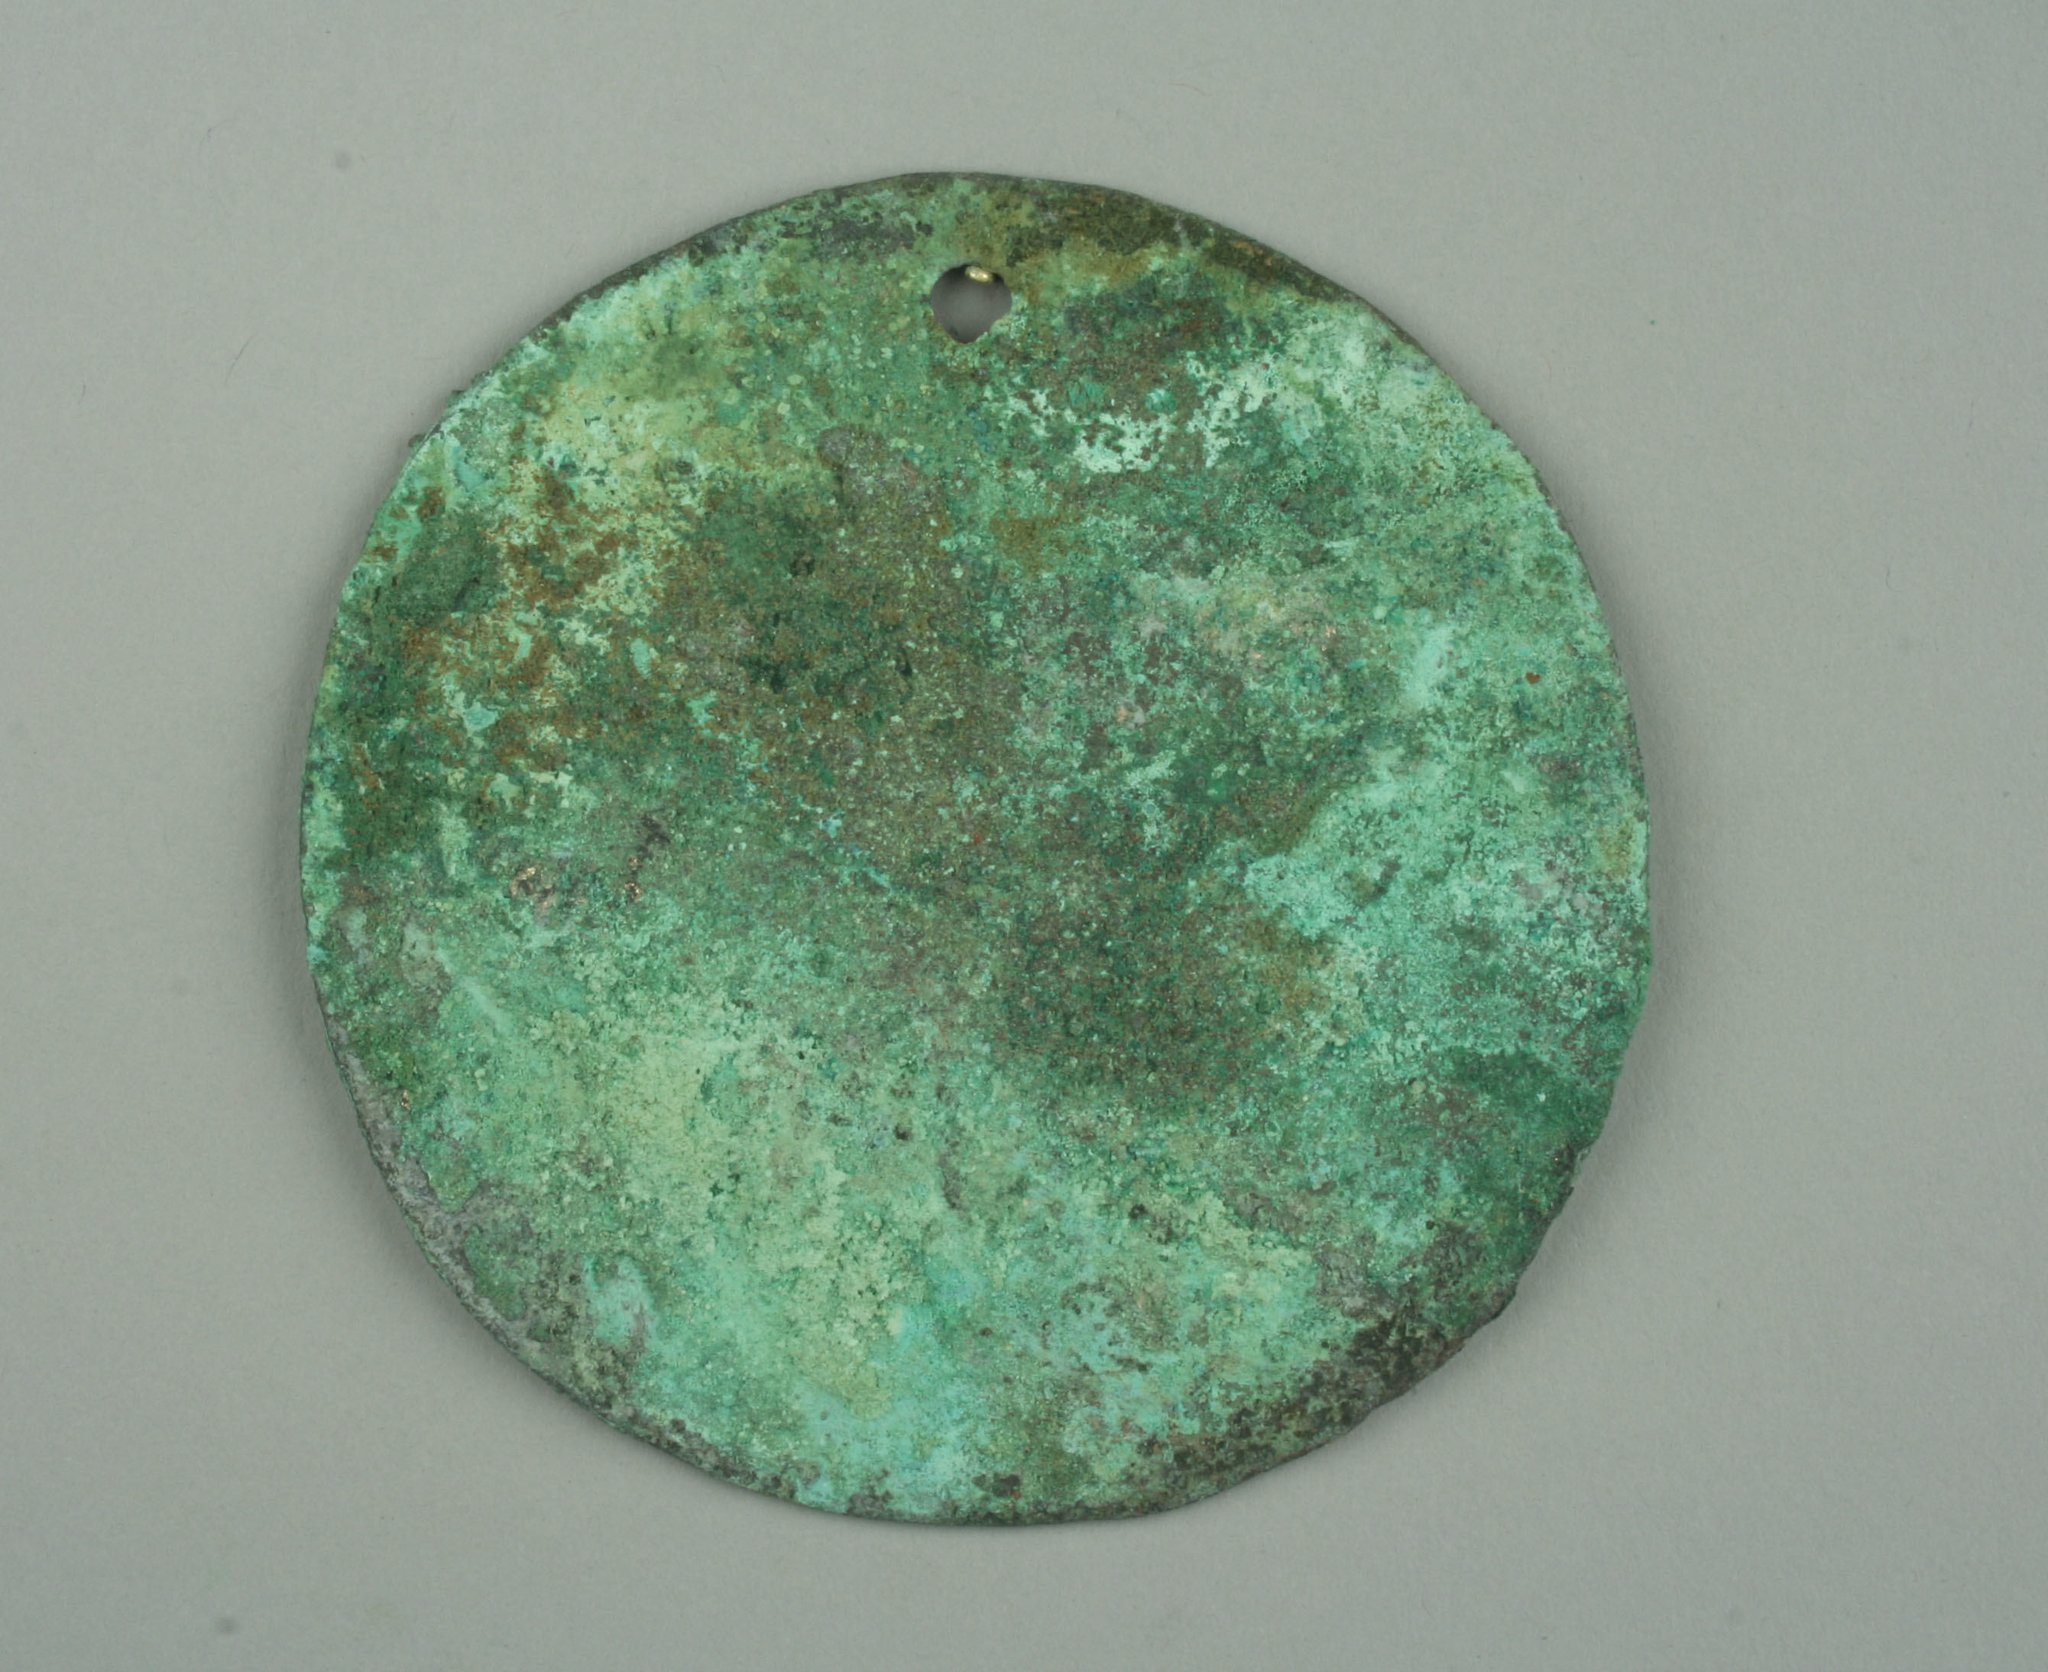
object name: plaque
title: Round Plaque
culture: vicús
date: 300 BCE-200 CE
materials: copper, gilt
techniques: hammering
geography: peru